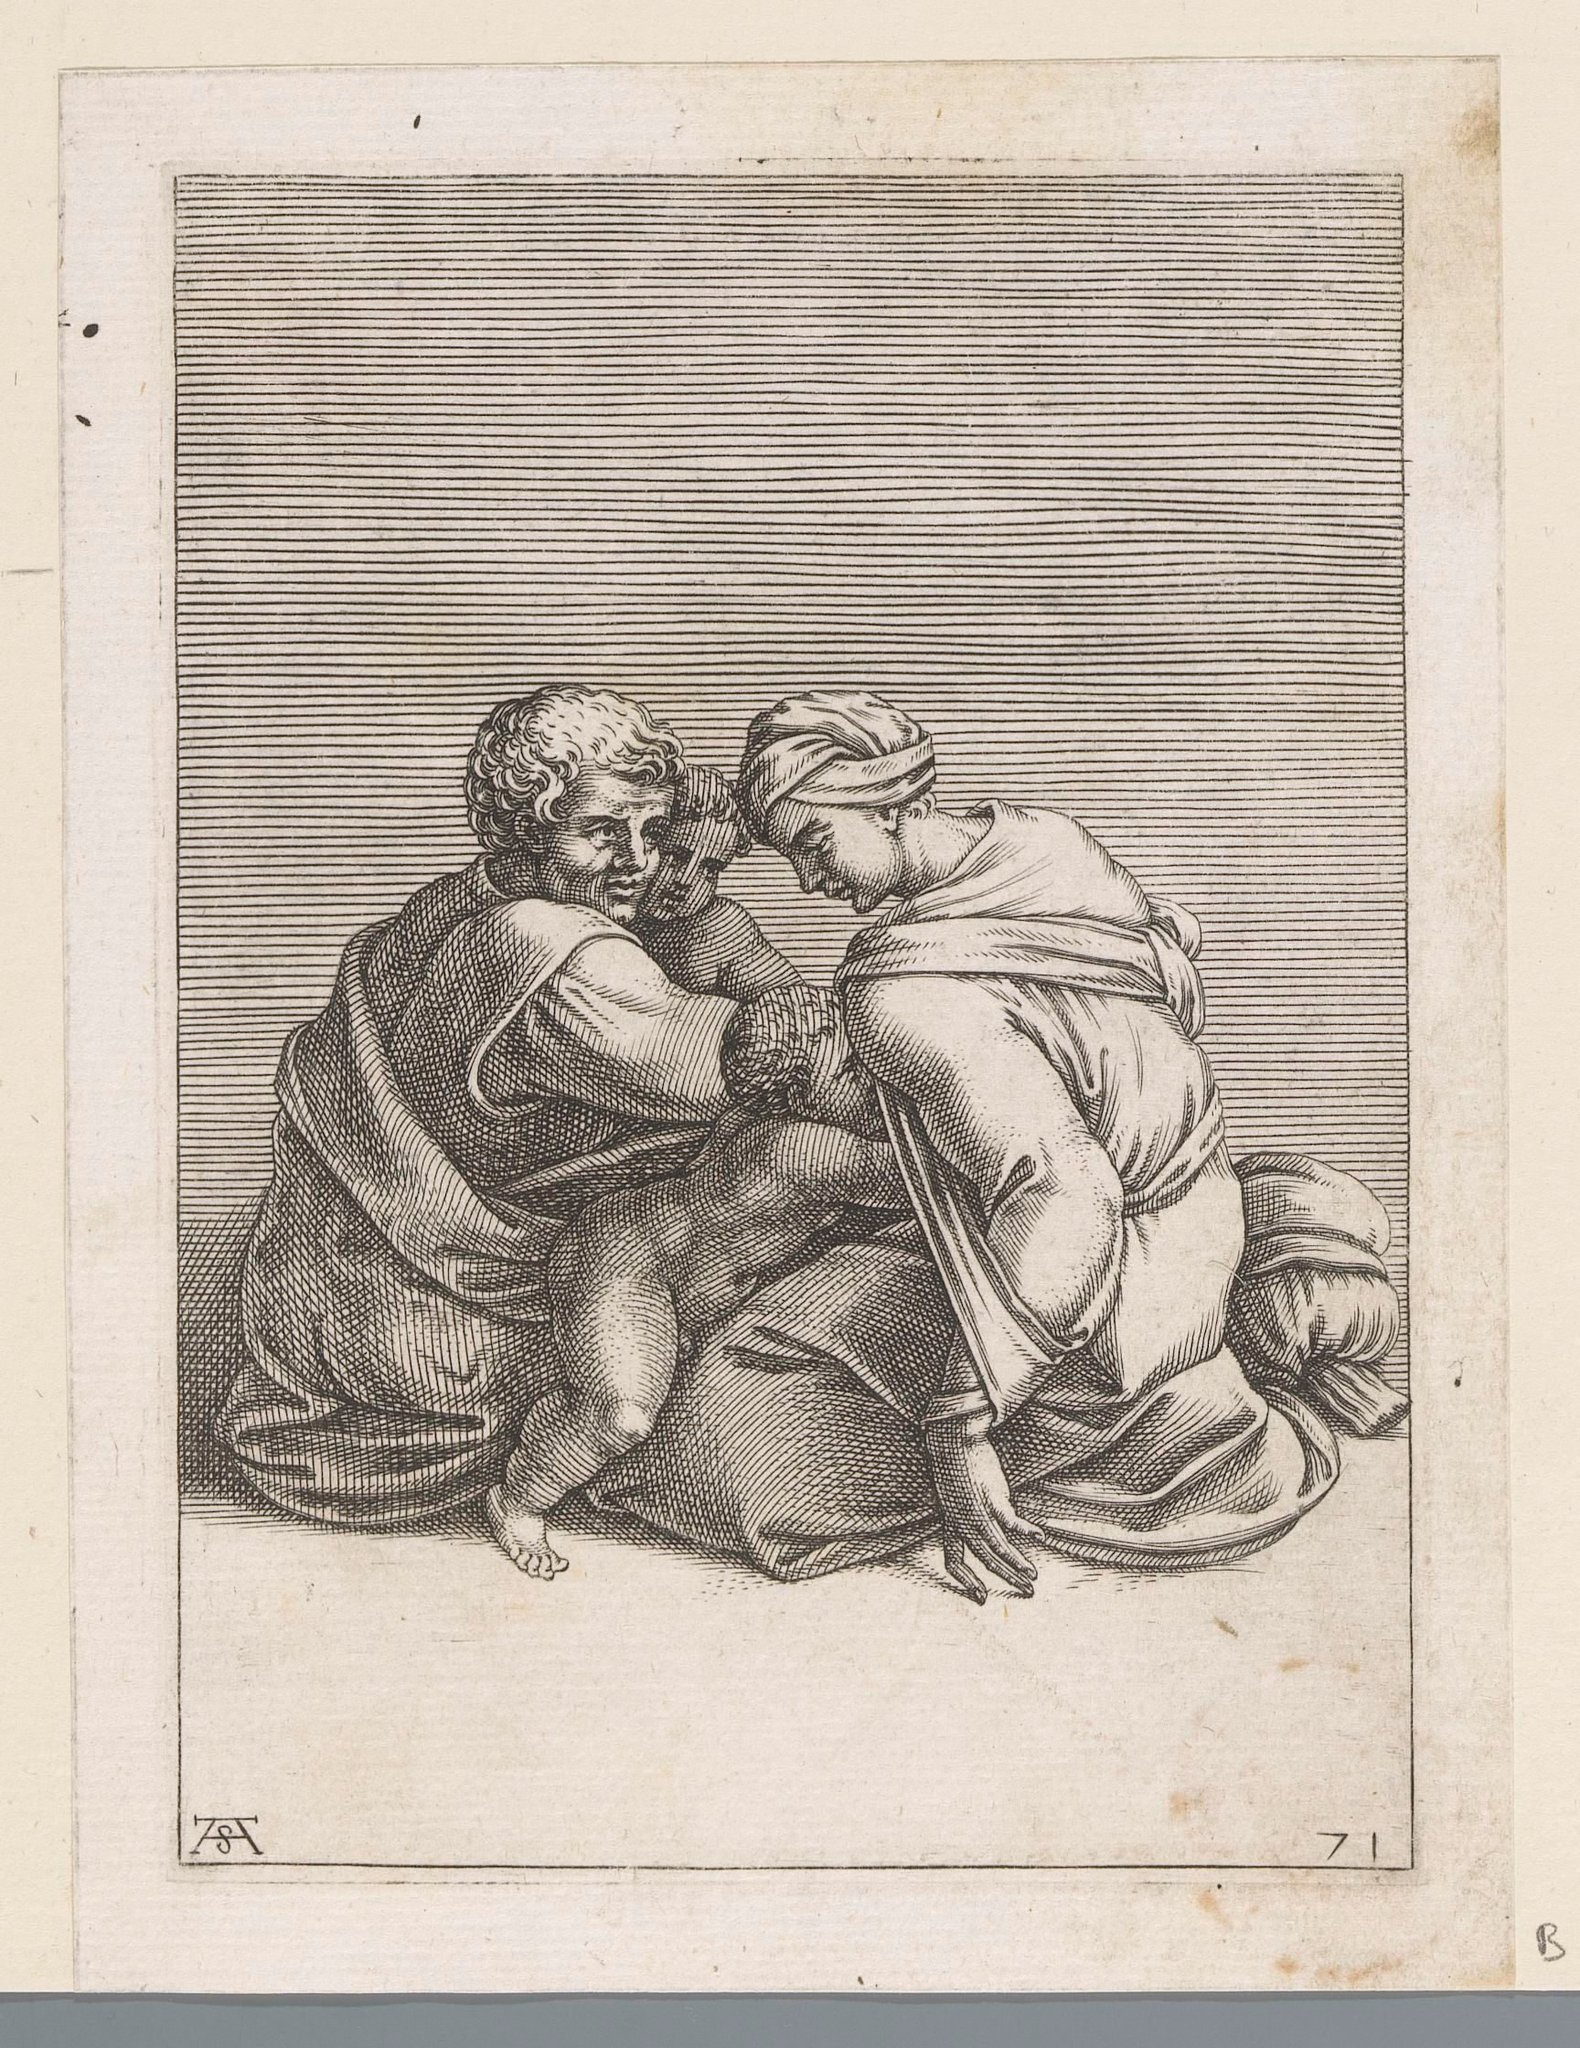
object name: print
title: Schilderingen in de Sixtijnse kapel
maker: adamo scultori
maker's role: painter, print maker, sculptor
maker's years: 1530-1585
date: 1585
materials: paper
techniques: engraving, intaglio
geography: vatican city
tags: sitting on the ground, mother and child(ren), woman and child(ren) (family group), father and child(ren), man and child(ren) (family group)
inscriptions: collector's mark: Lugt 240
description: Deze prent maakt deel uit van een serie bestaande uit een titelprent en 72 prenten naar schilderingen door Michelangelo in de Sixtijnse Kapel in het Vaticaan.